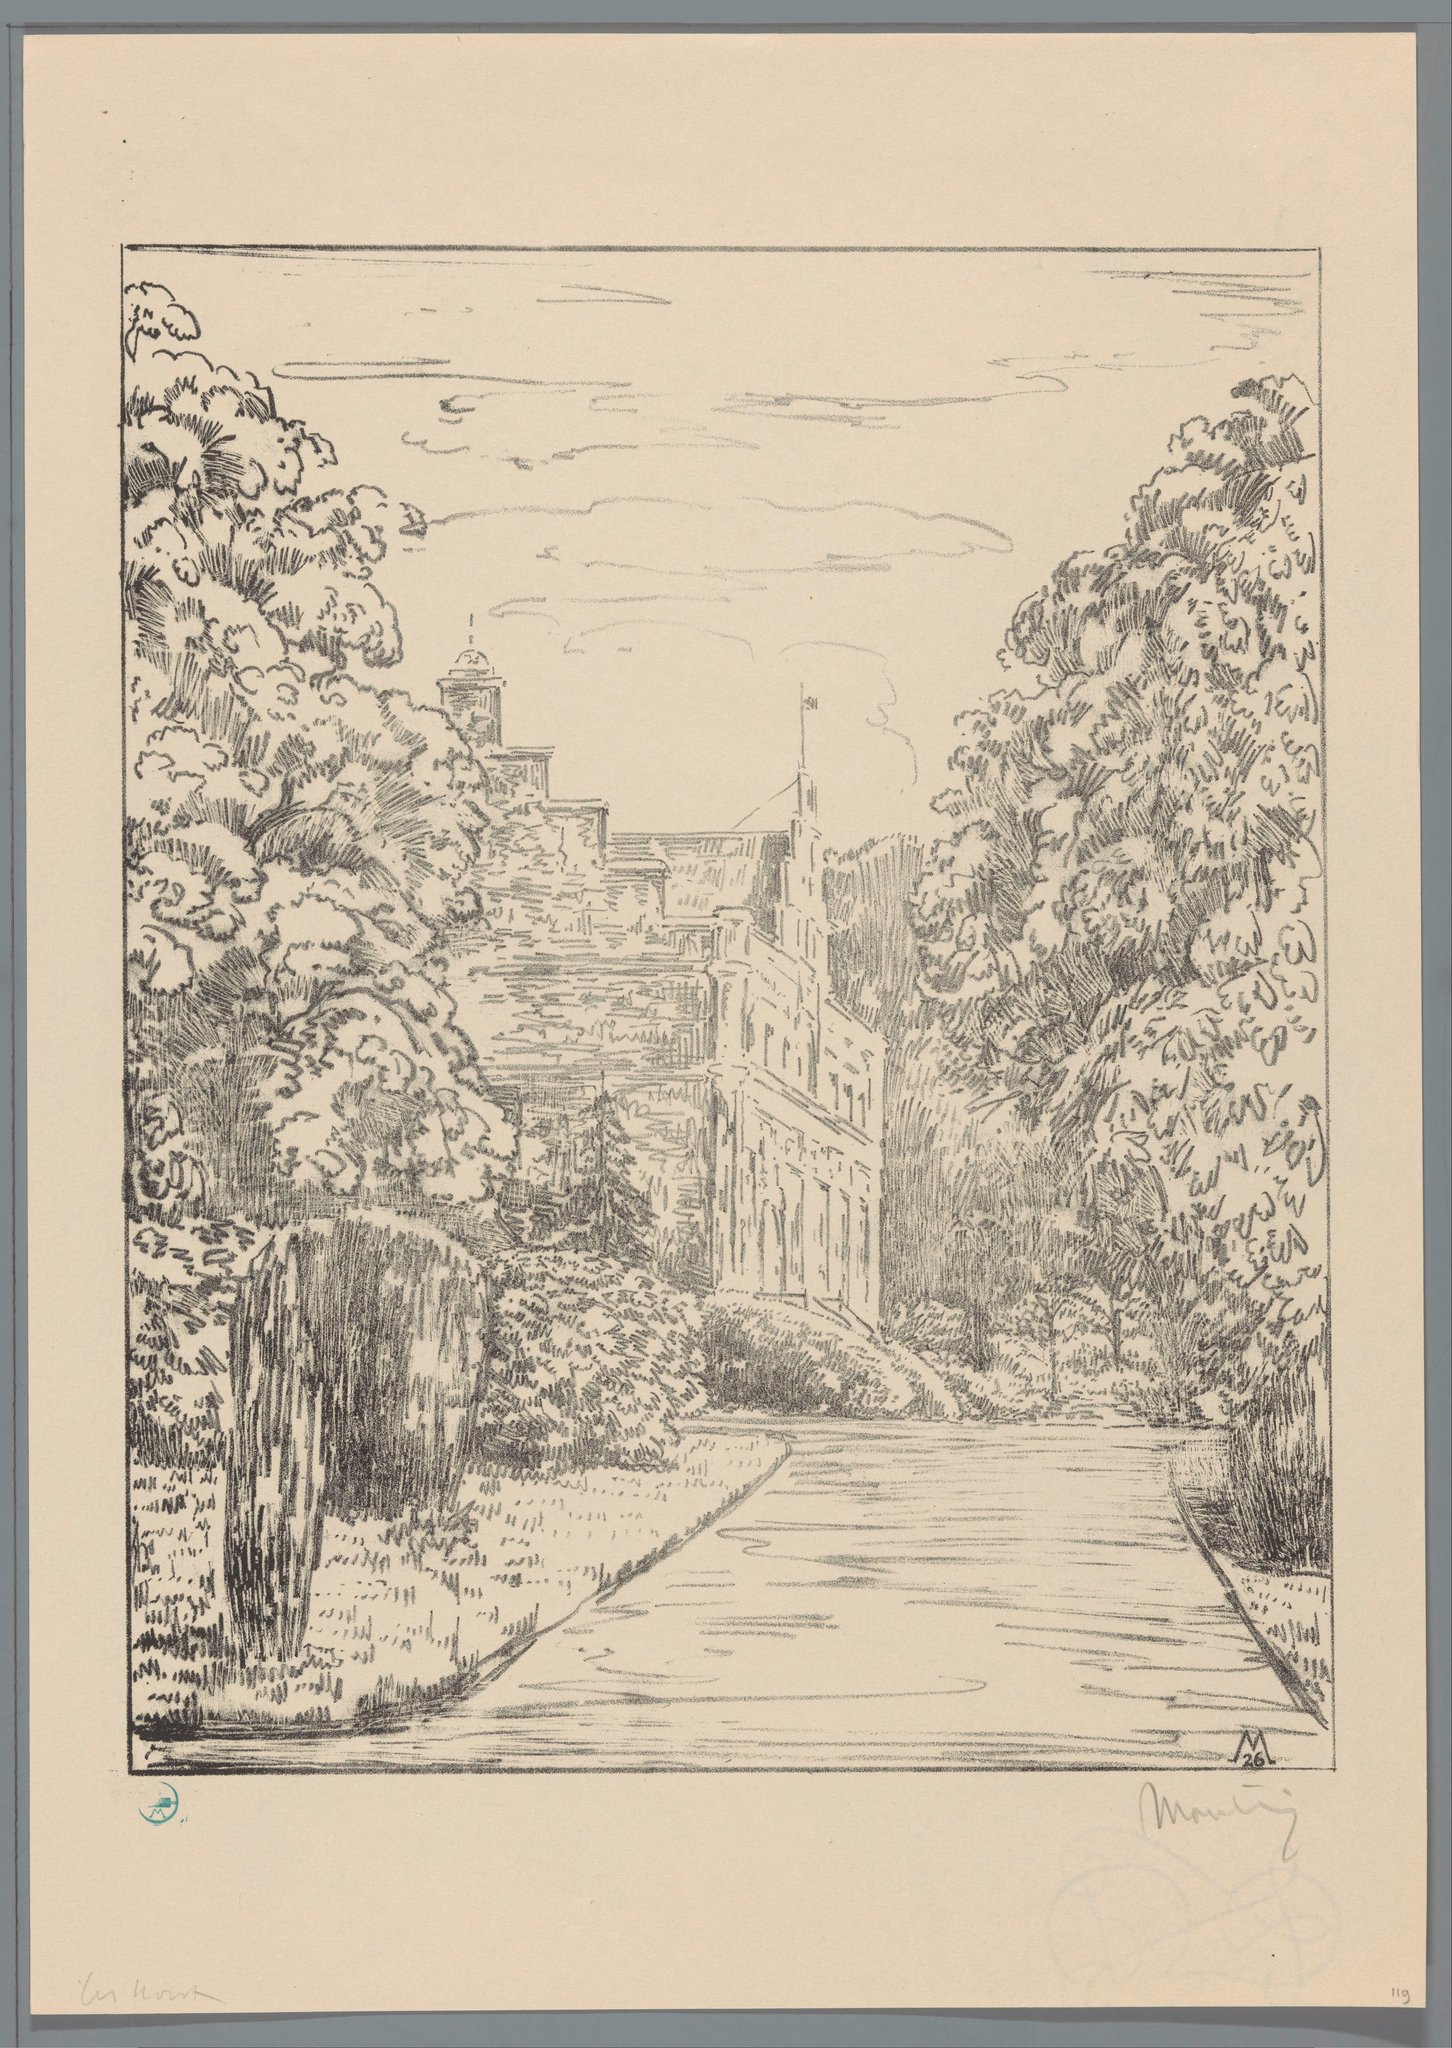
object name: print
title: Gezicht op jachthuis Ter Horst vanaf oprijlaan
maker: simon moulijn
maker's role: draughtsman, print maker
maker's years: 1866-1948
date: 1926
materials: paper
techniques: lithograph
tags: garden approach, garden drive, country-house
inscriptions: stamp: Lugt 2362b, collector's mark: Lugt 2228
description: Prent gebruikt voor: Moulijn, Simon en Gelder, Hendrik Enno van. Oude buitenplaatsen rondom 's-Gravenhage. 's-Gravenhage: Gemeentebestuur, 1929.